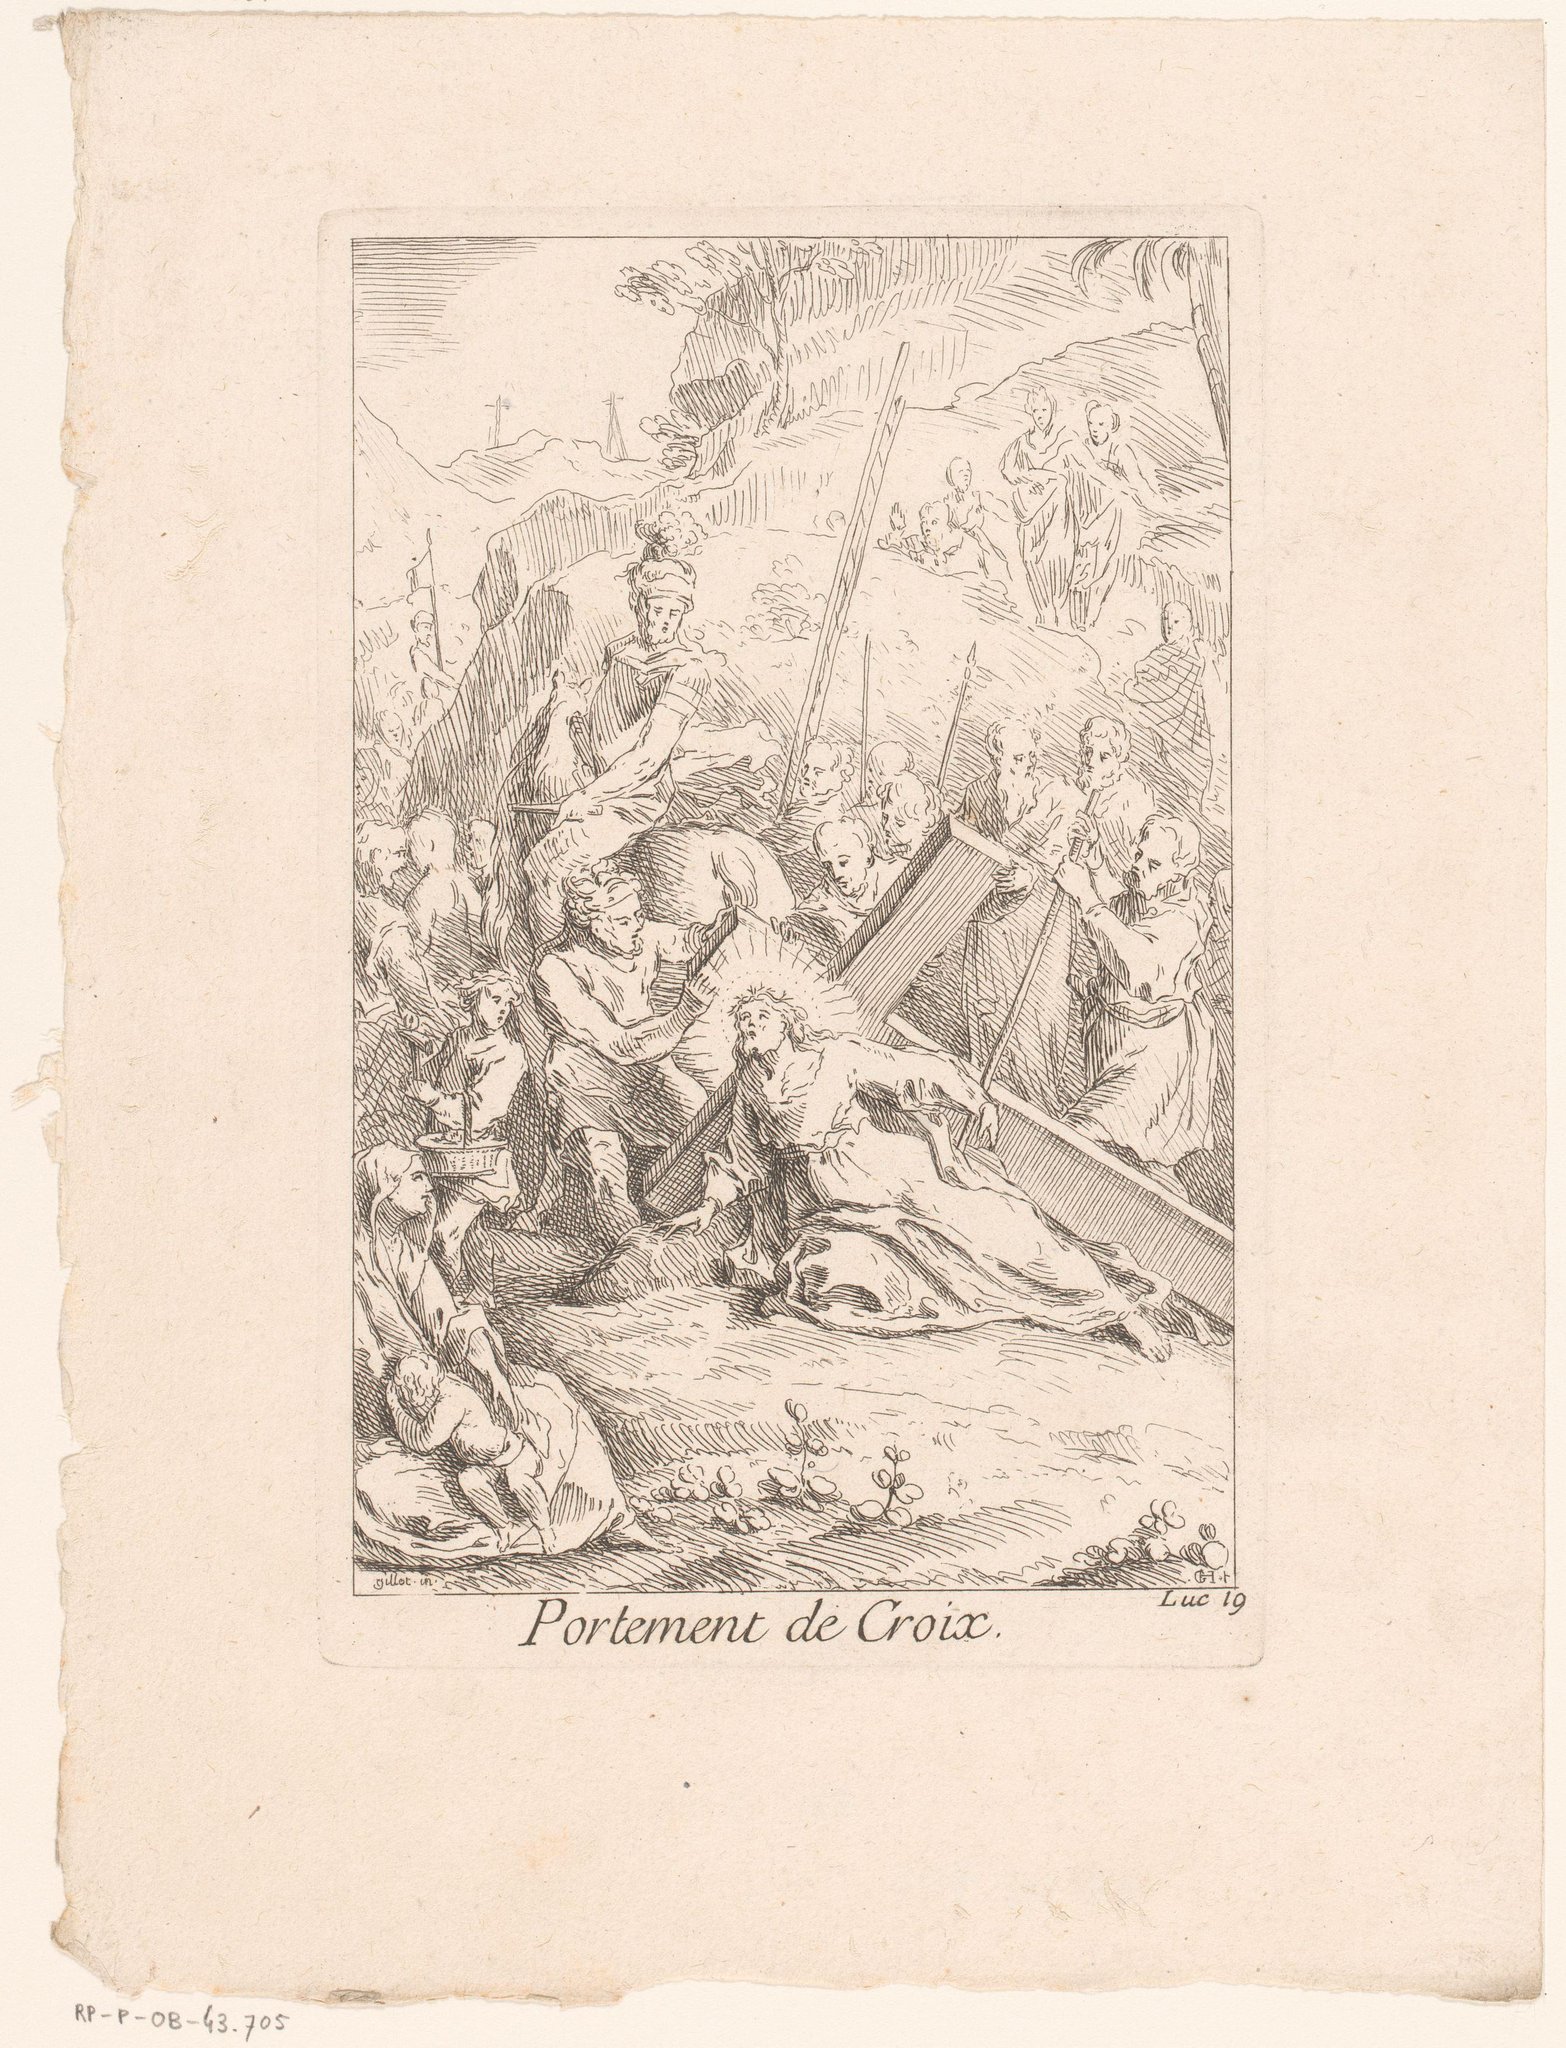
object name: print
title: La Vie de N.S. Jesus C.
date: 1705-1732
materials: paper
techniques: etching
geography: paris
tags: christ collapsing ~ carrying of the cross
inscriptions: collector's mark: Lugt 2228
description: Maakt deel uit van een serie met zestig prenten met als thema het leven van Christus.